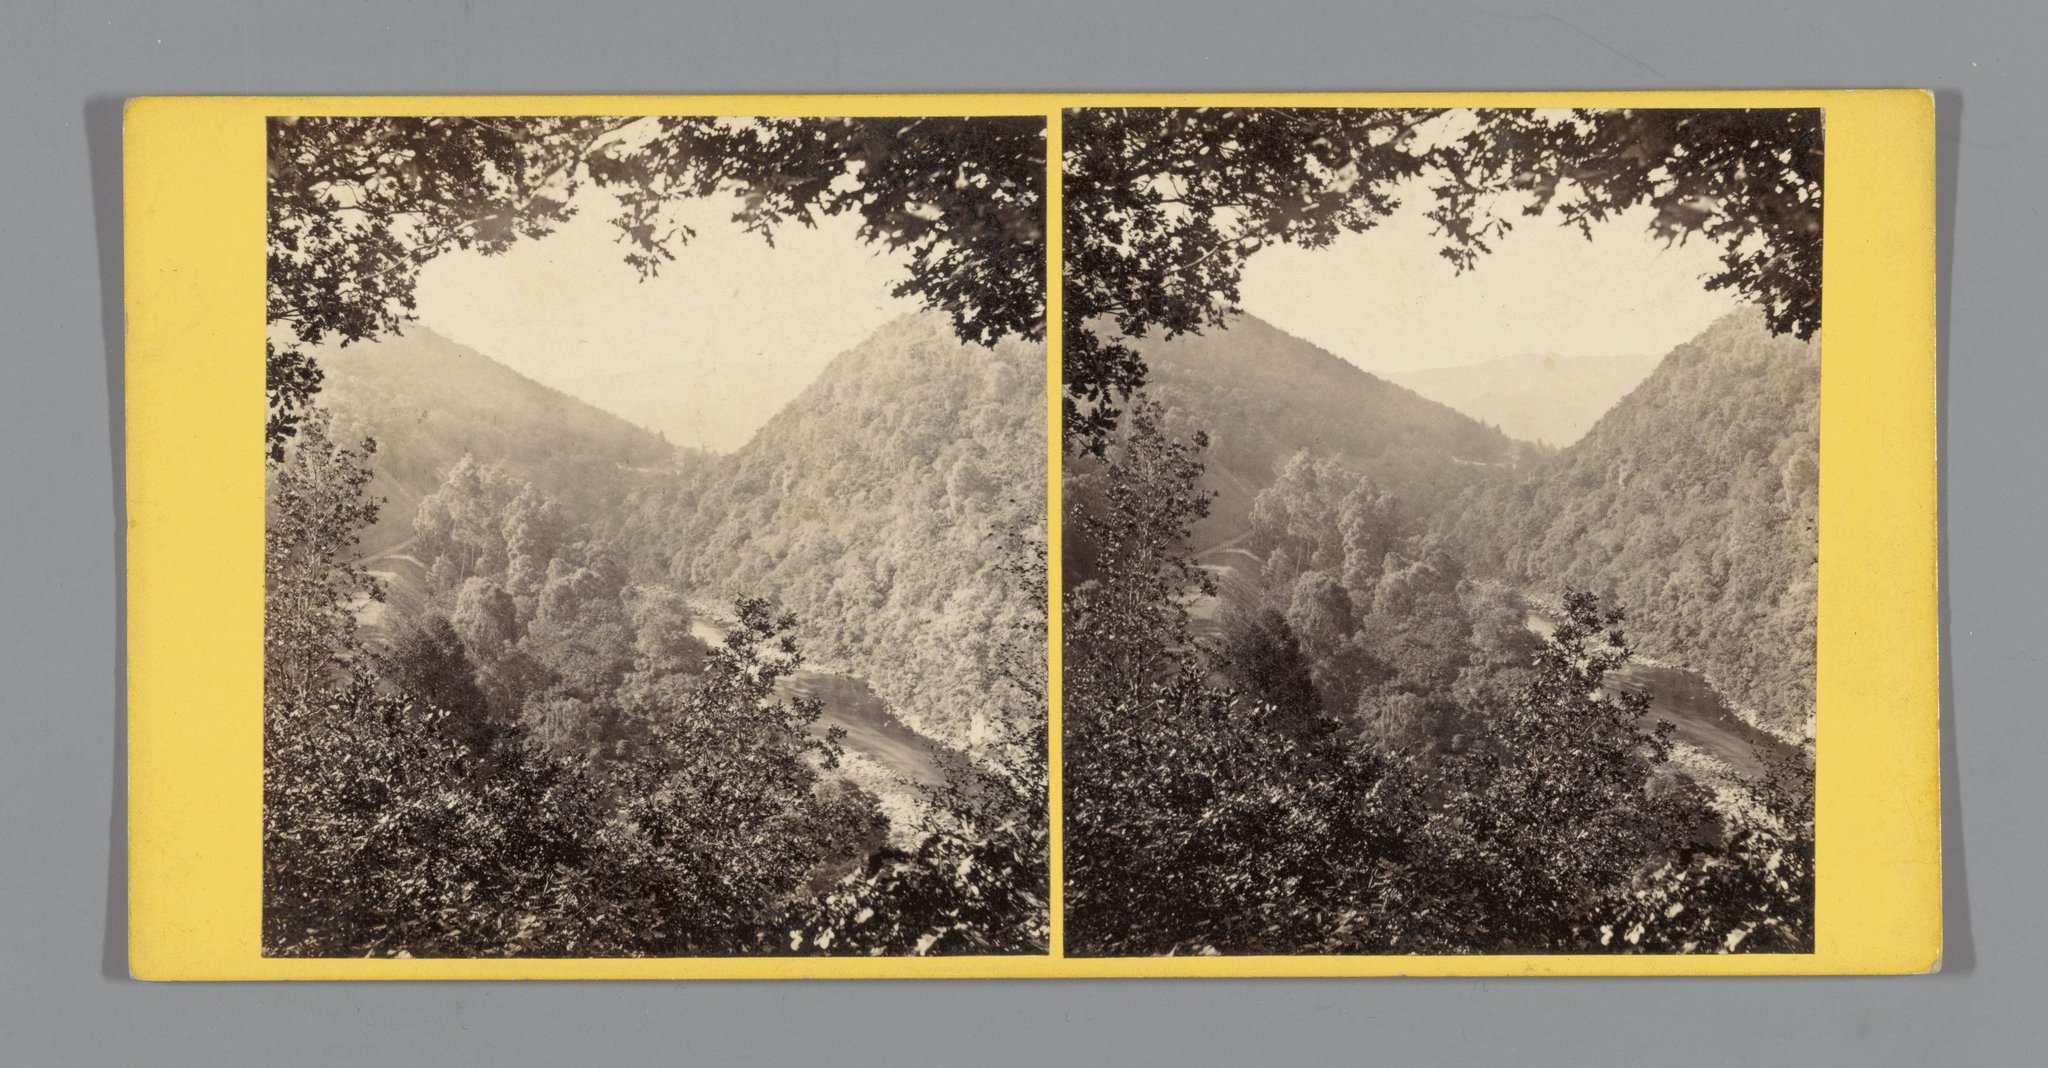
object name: stereograph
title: Pass of Killiecrankie, looking down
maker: george washington wilson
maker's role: publisher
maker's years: 1823-1893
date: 1850-1880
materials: cardboard, photographic support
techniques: albumen print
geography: killiecrankie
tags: dale, valley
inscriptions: name: ‘Registered G. W. Wilson, Photographer, Aberdeen.’, number: ‘No. 470.’